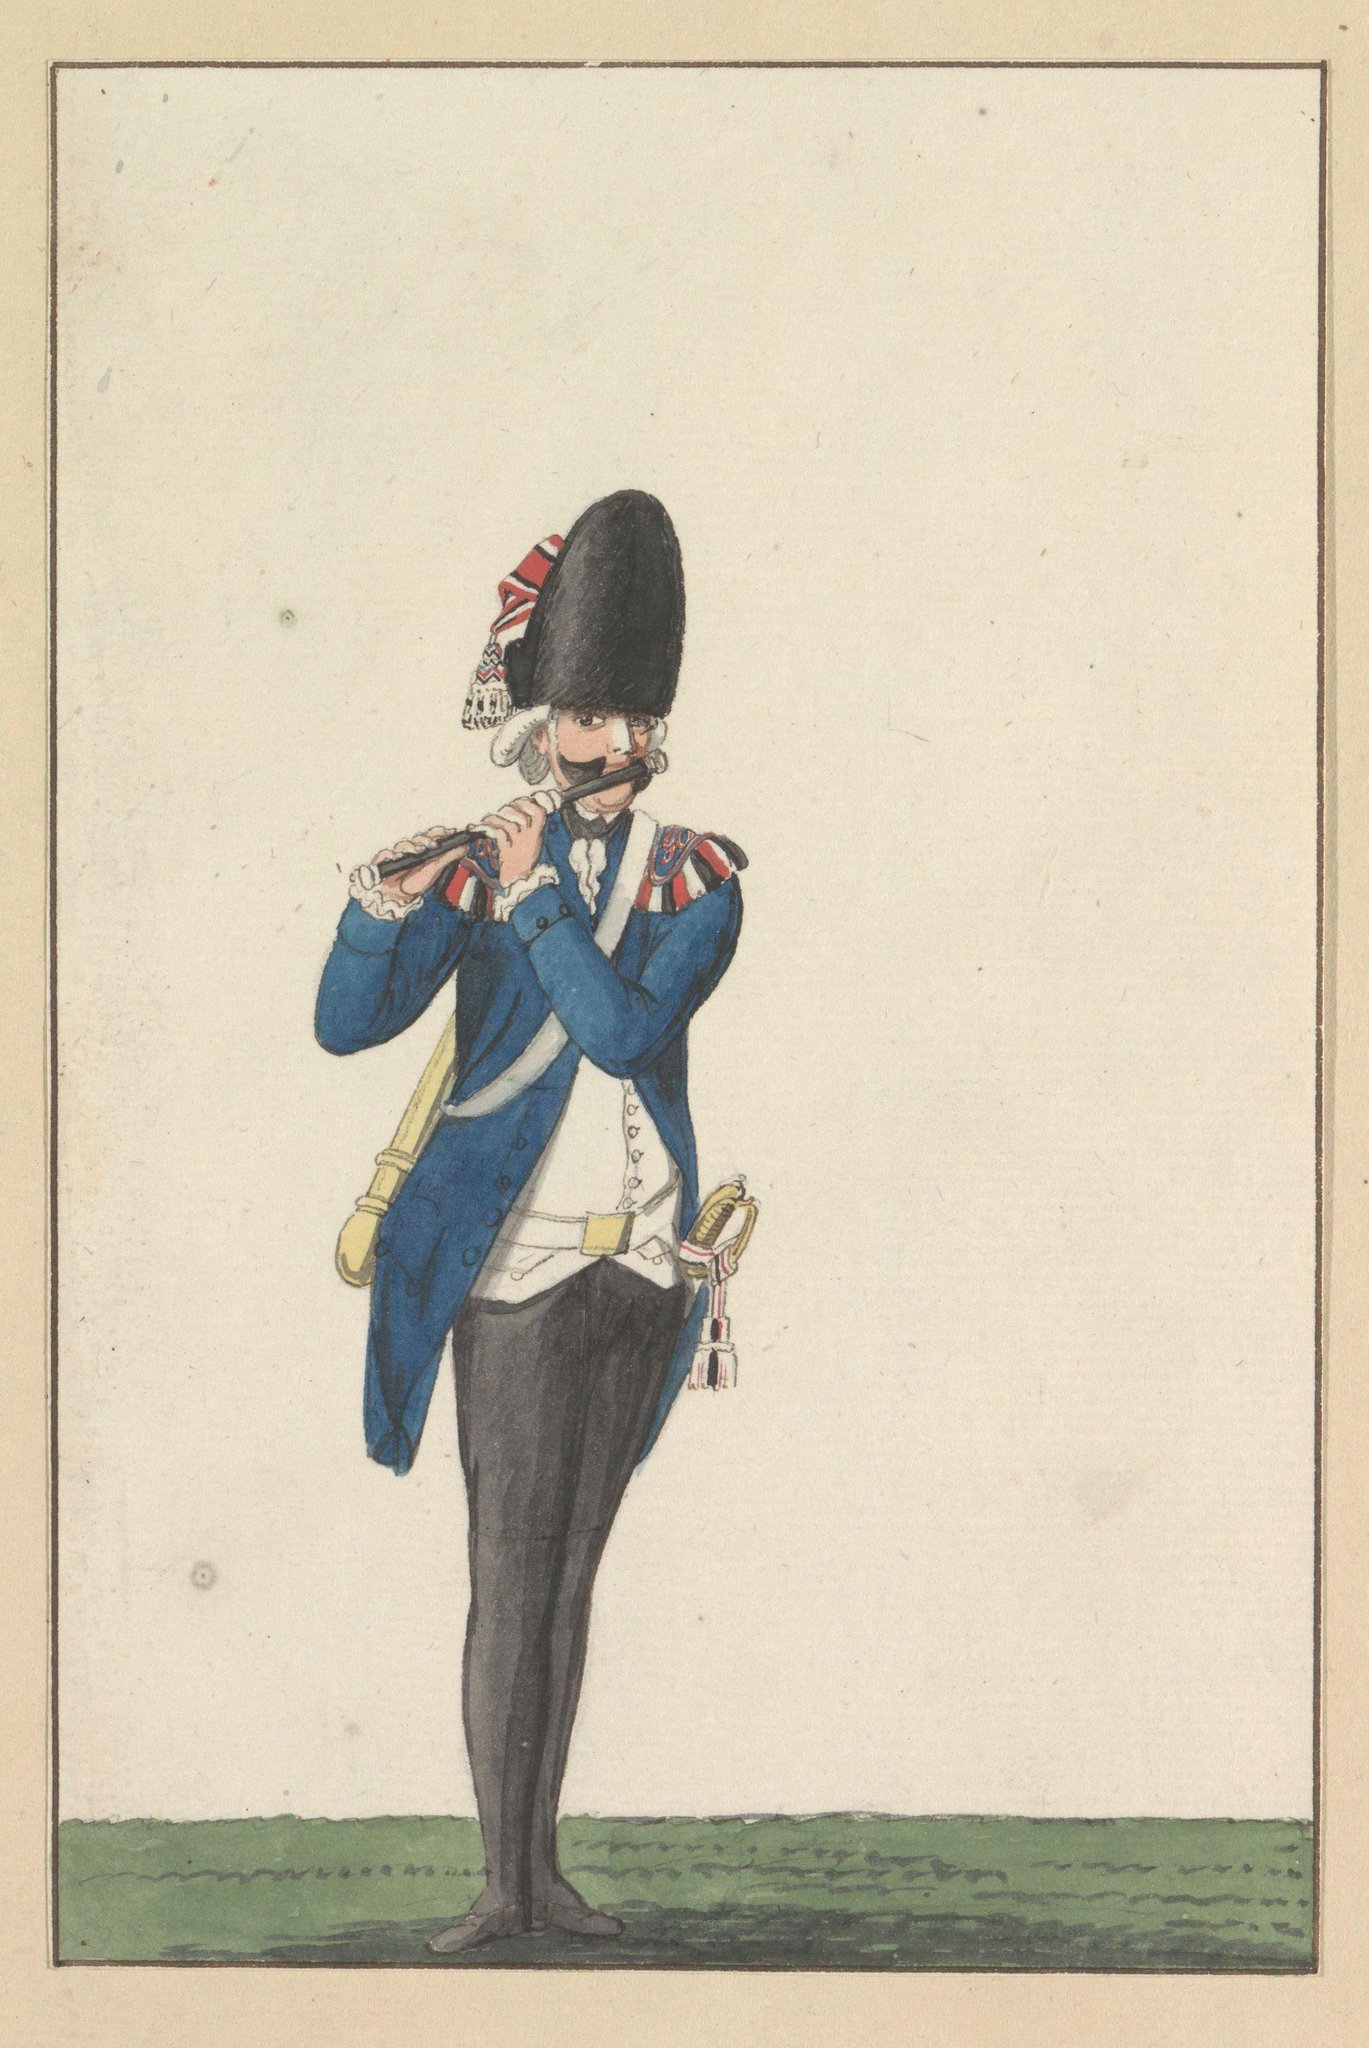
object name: costume print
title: A fifer of the Society for the Benefit of the Militia in Amsterdam, 1787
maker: Anonymous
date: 1787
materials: paper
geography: amsterdam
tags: (military) uniforms (+ citizen soldiery, civil guard, citizen militia), military music, amsterdam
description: Pijper spelend op zijn fluit. Onderdeel van het album met veertien ingeplakte gekleurde tekeningen van de uniformen van schutters van het patriotse Genootschap tot Nut der Schutterij te Amsterdam in het jaar 1787.